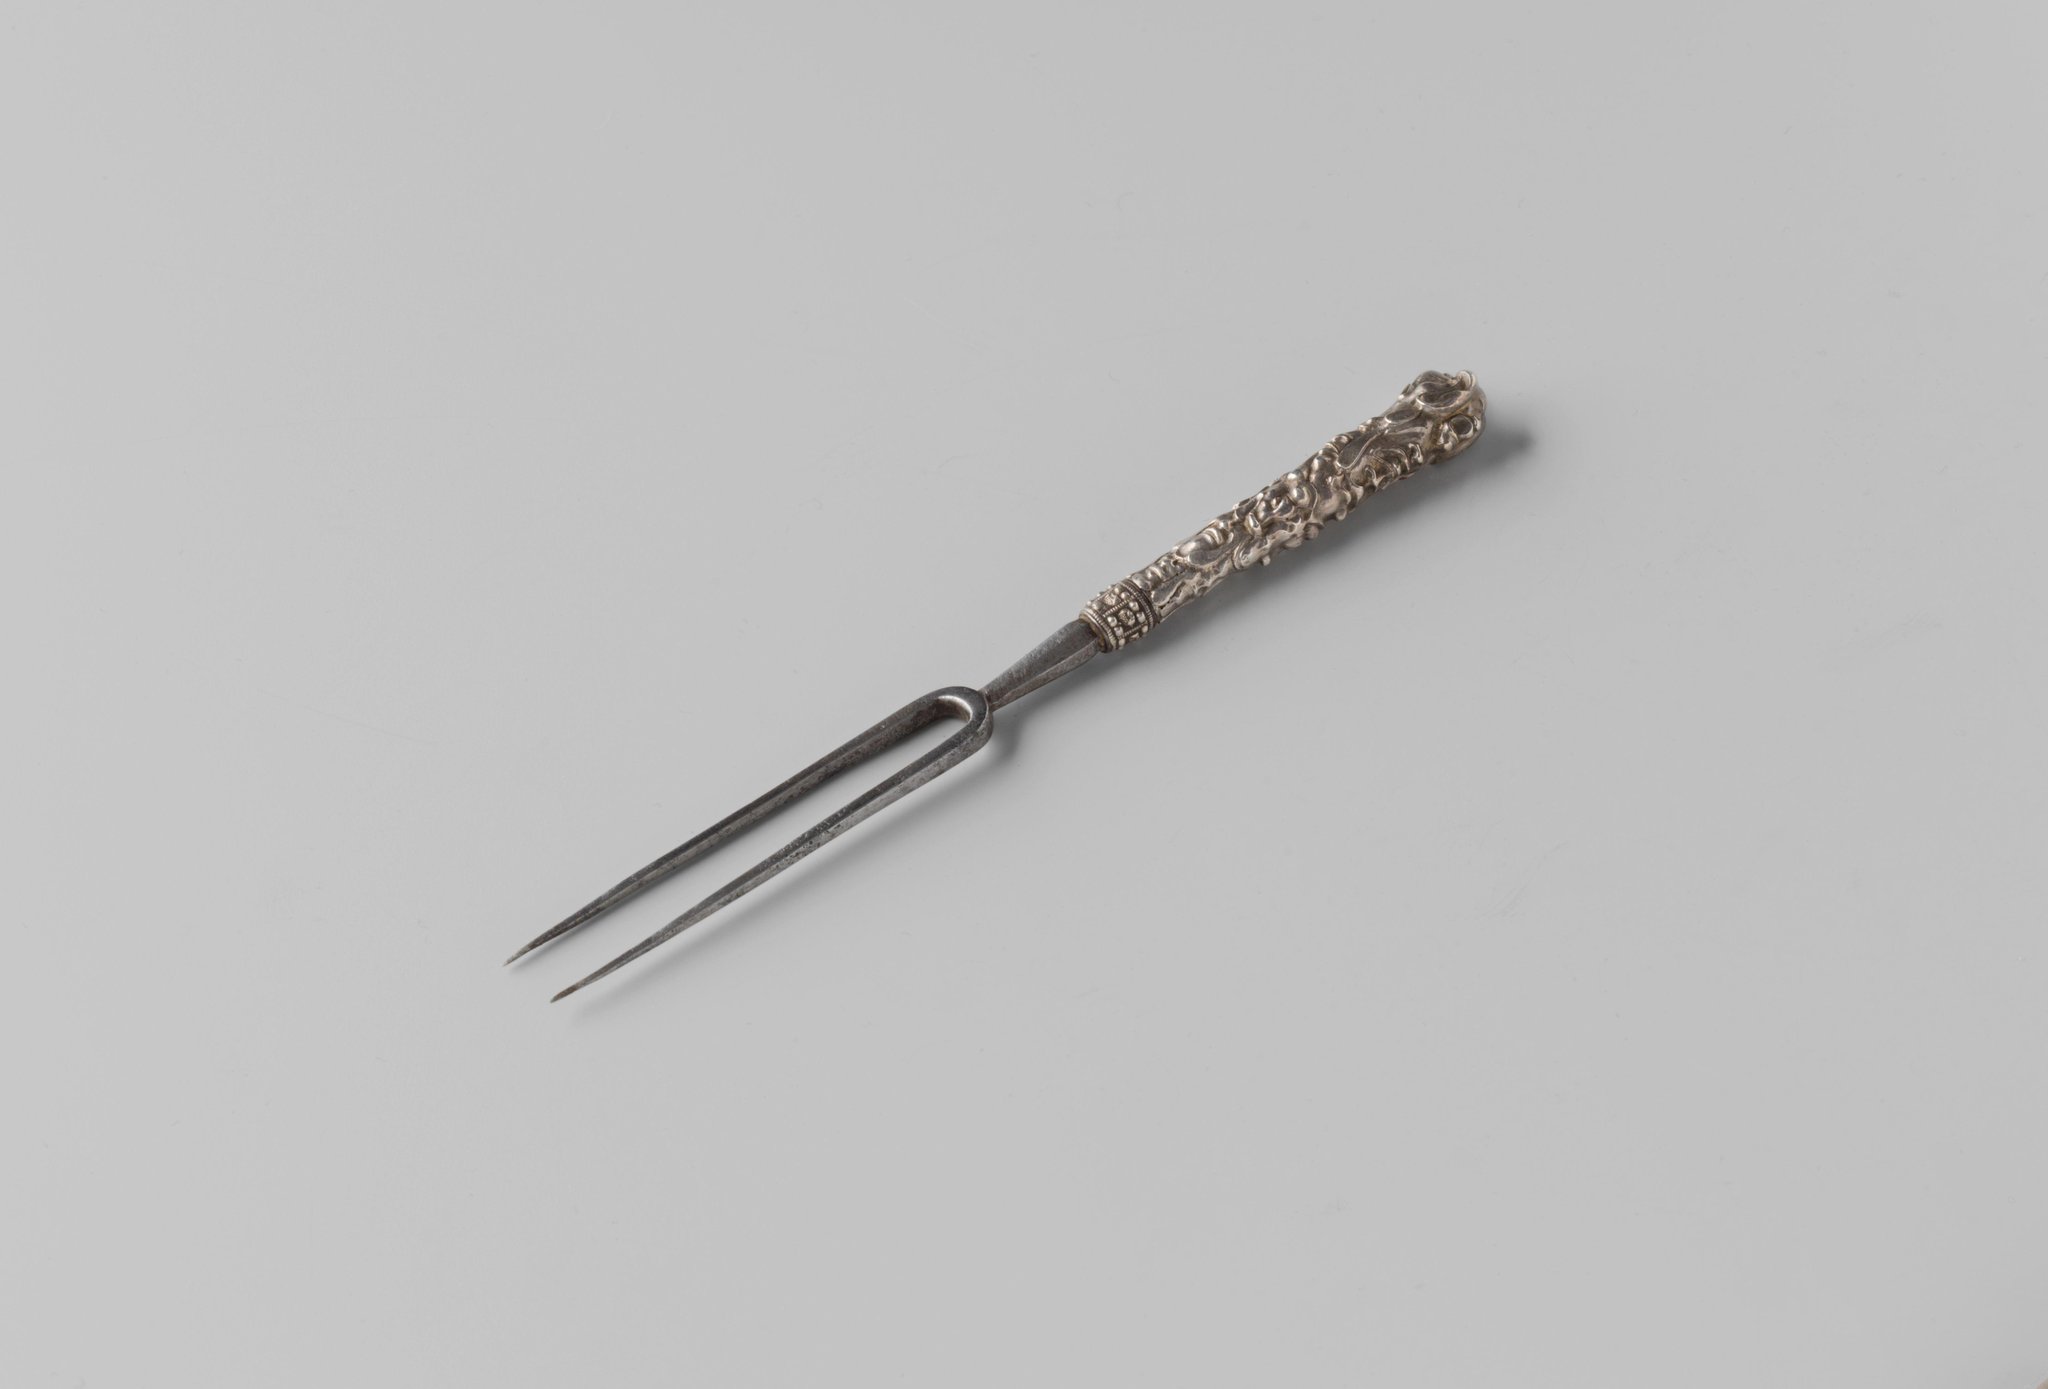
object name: fork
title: Vork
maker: Anonymous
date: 1600-1650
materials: silver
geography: north germany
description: Vork met twee lange tanden en een zilveren heft.